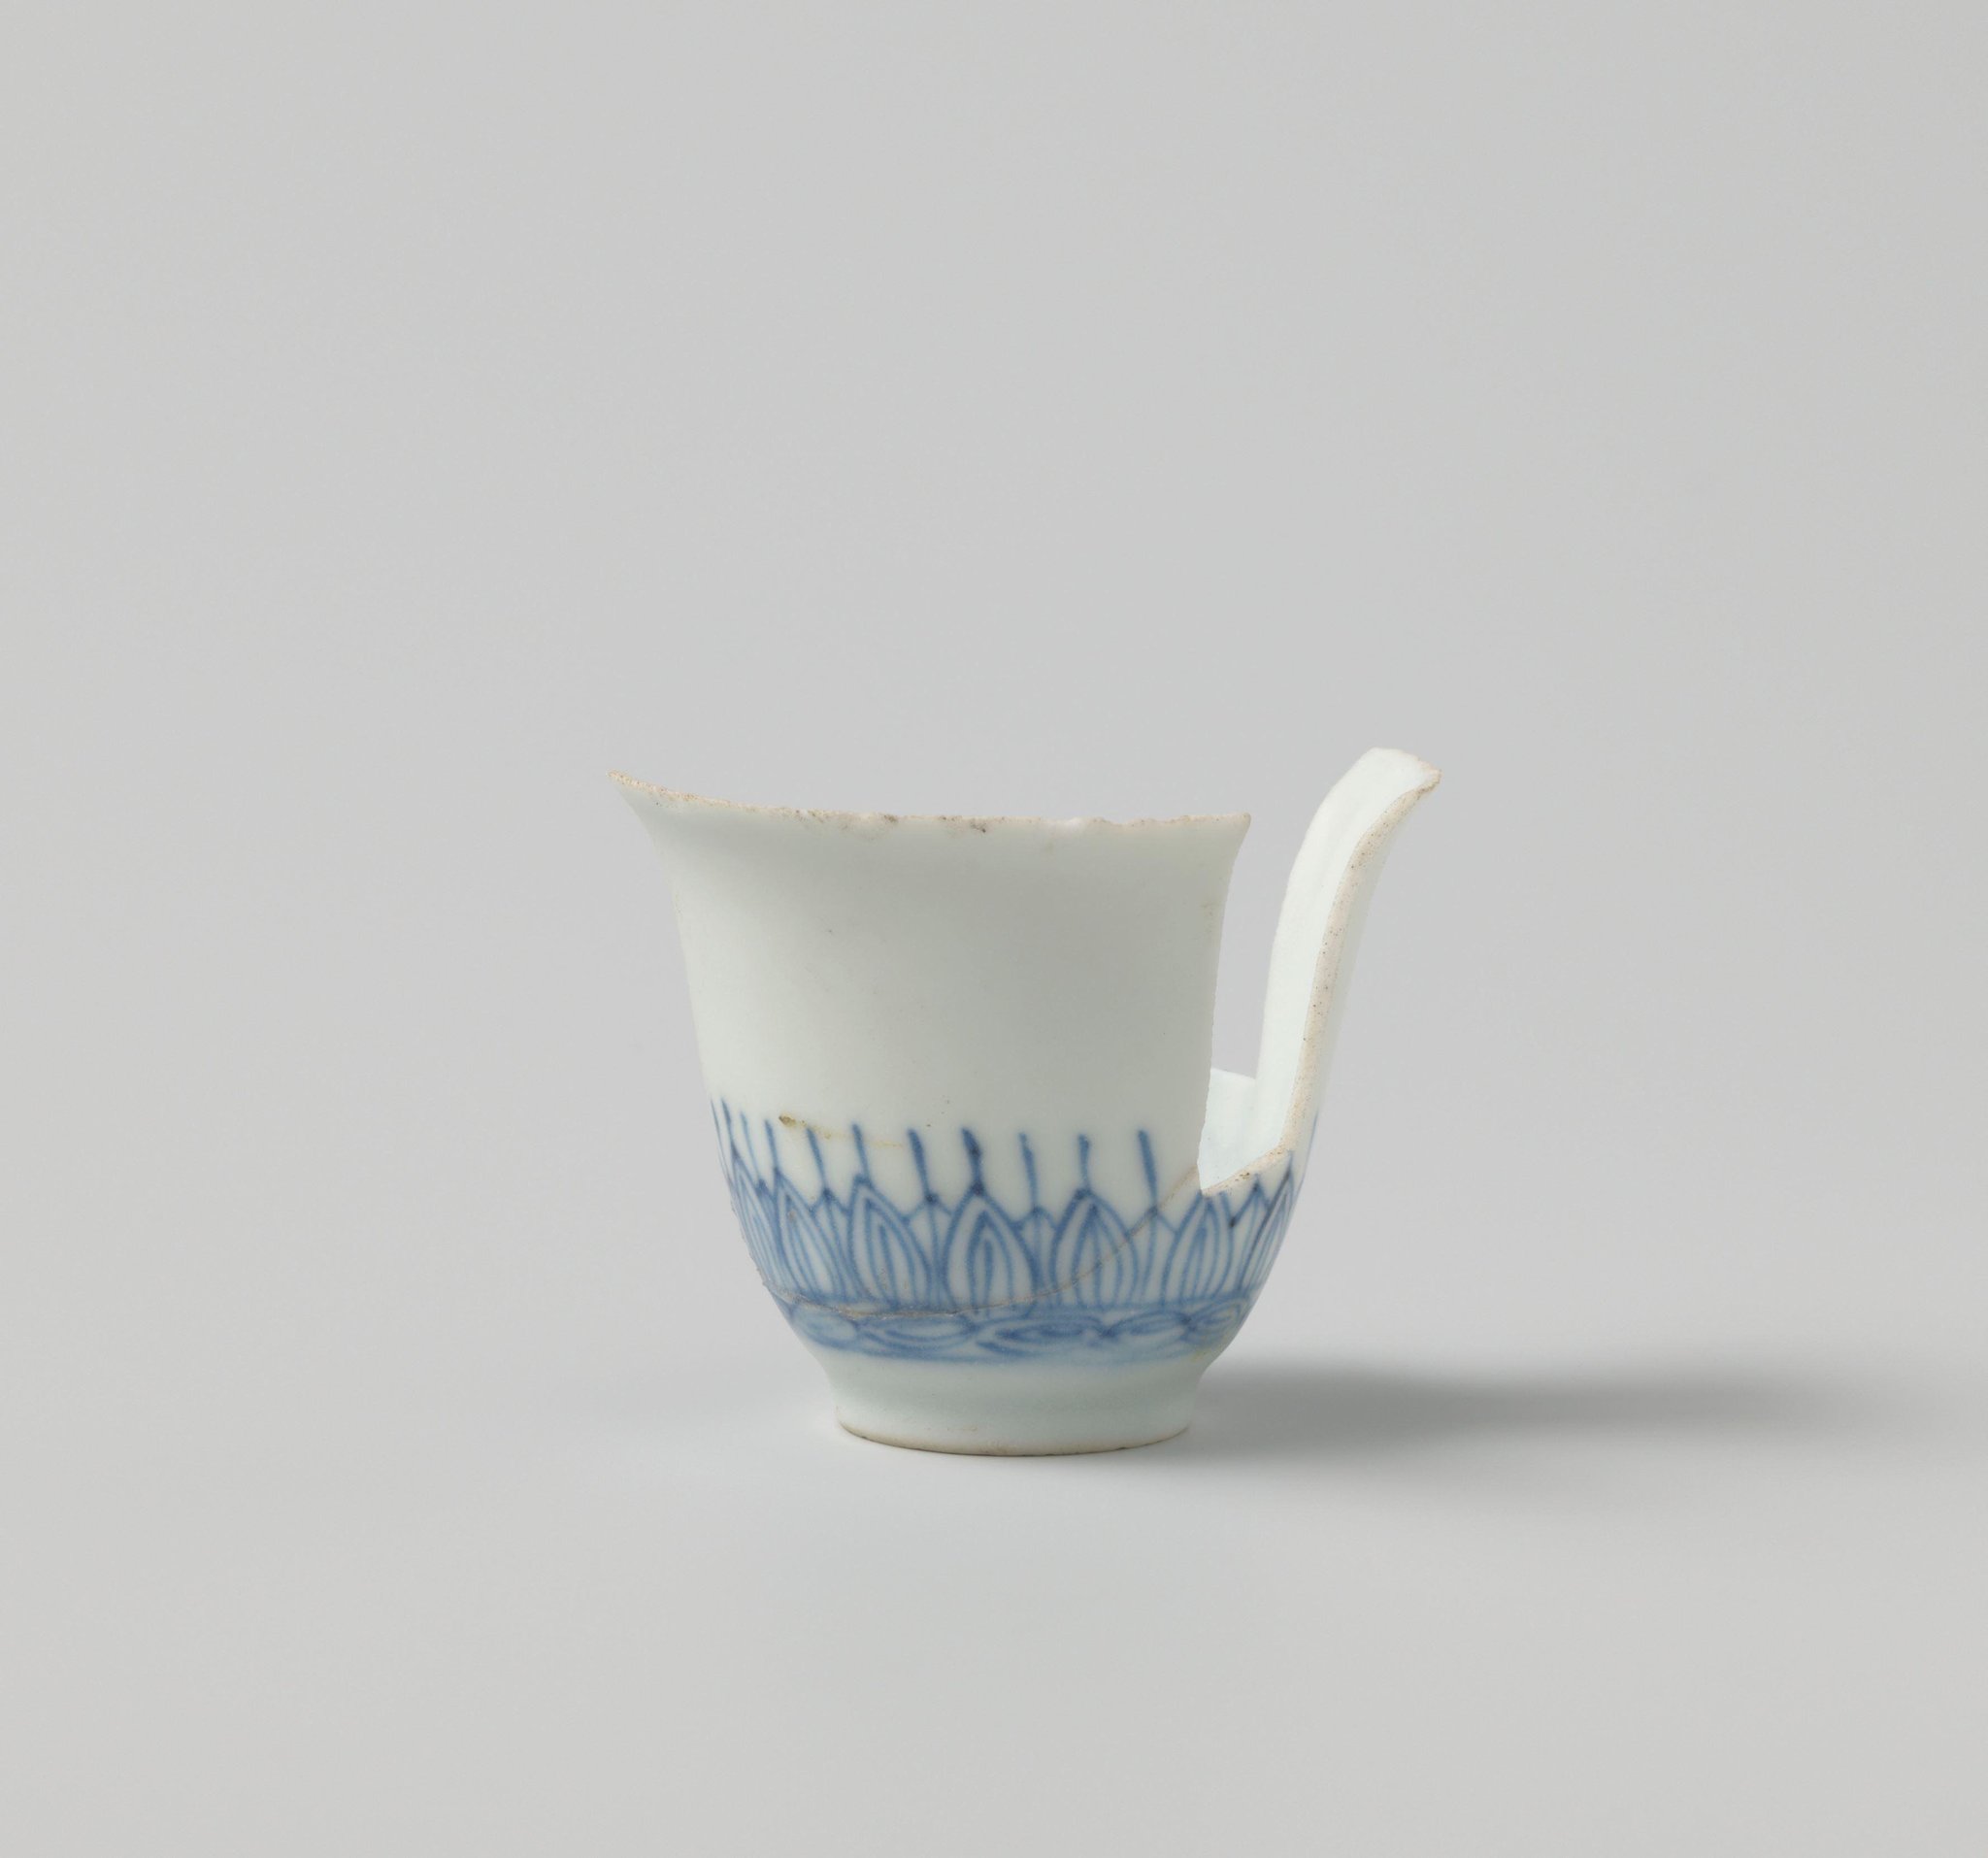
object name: wine cup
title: Fragment wijnkom uit V.O.C.-schip de 'Witte Leeuw'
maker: Anonymous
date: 1613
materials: porcelain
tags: verenigde oostindische compagnie, sint-helena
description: Fragment wijnkom uit V.O.C.-schip de 'Witte Leeuw', 55% aanwezig.